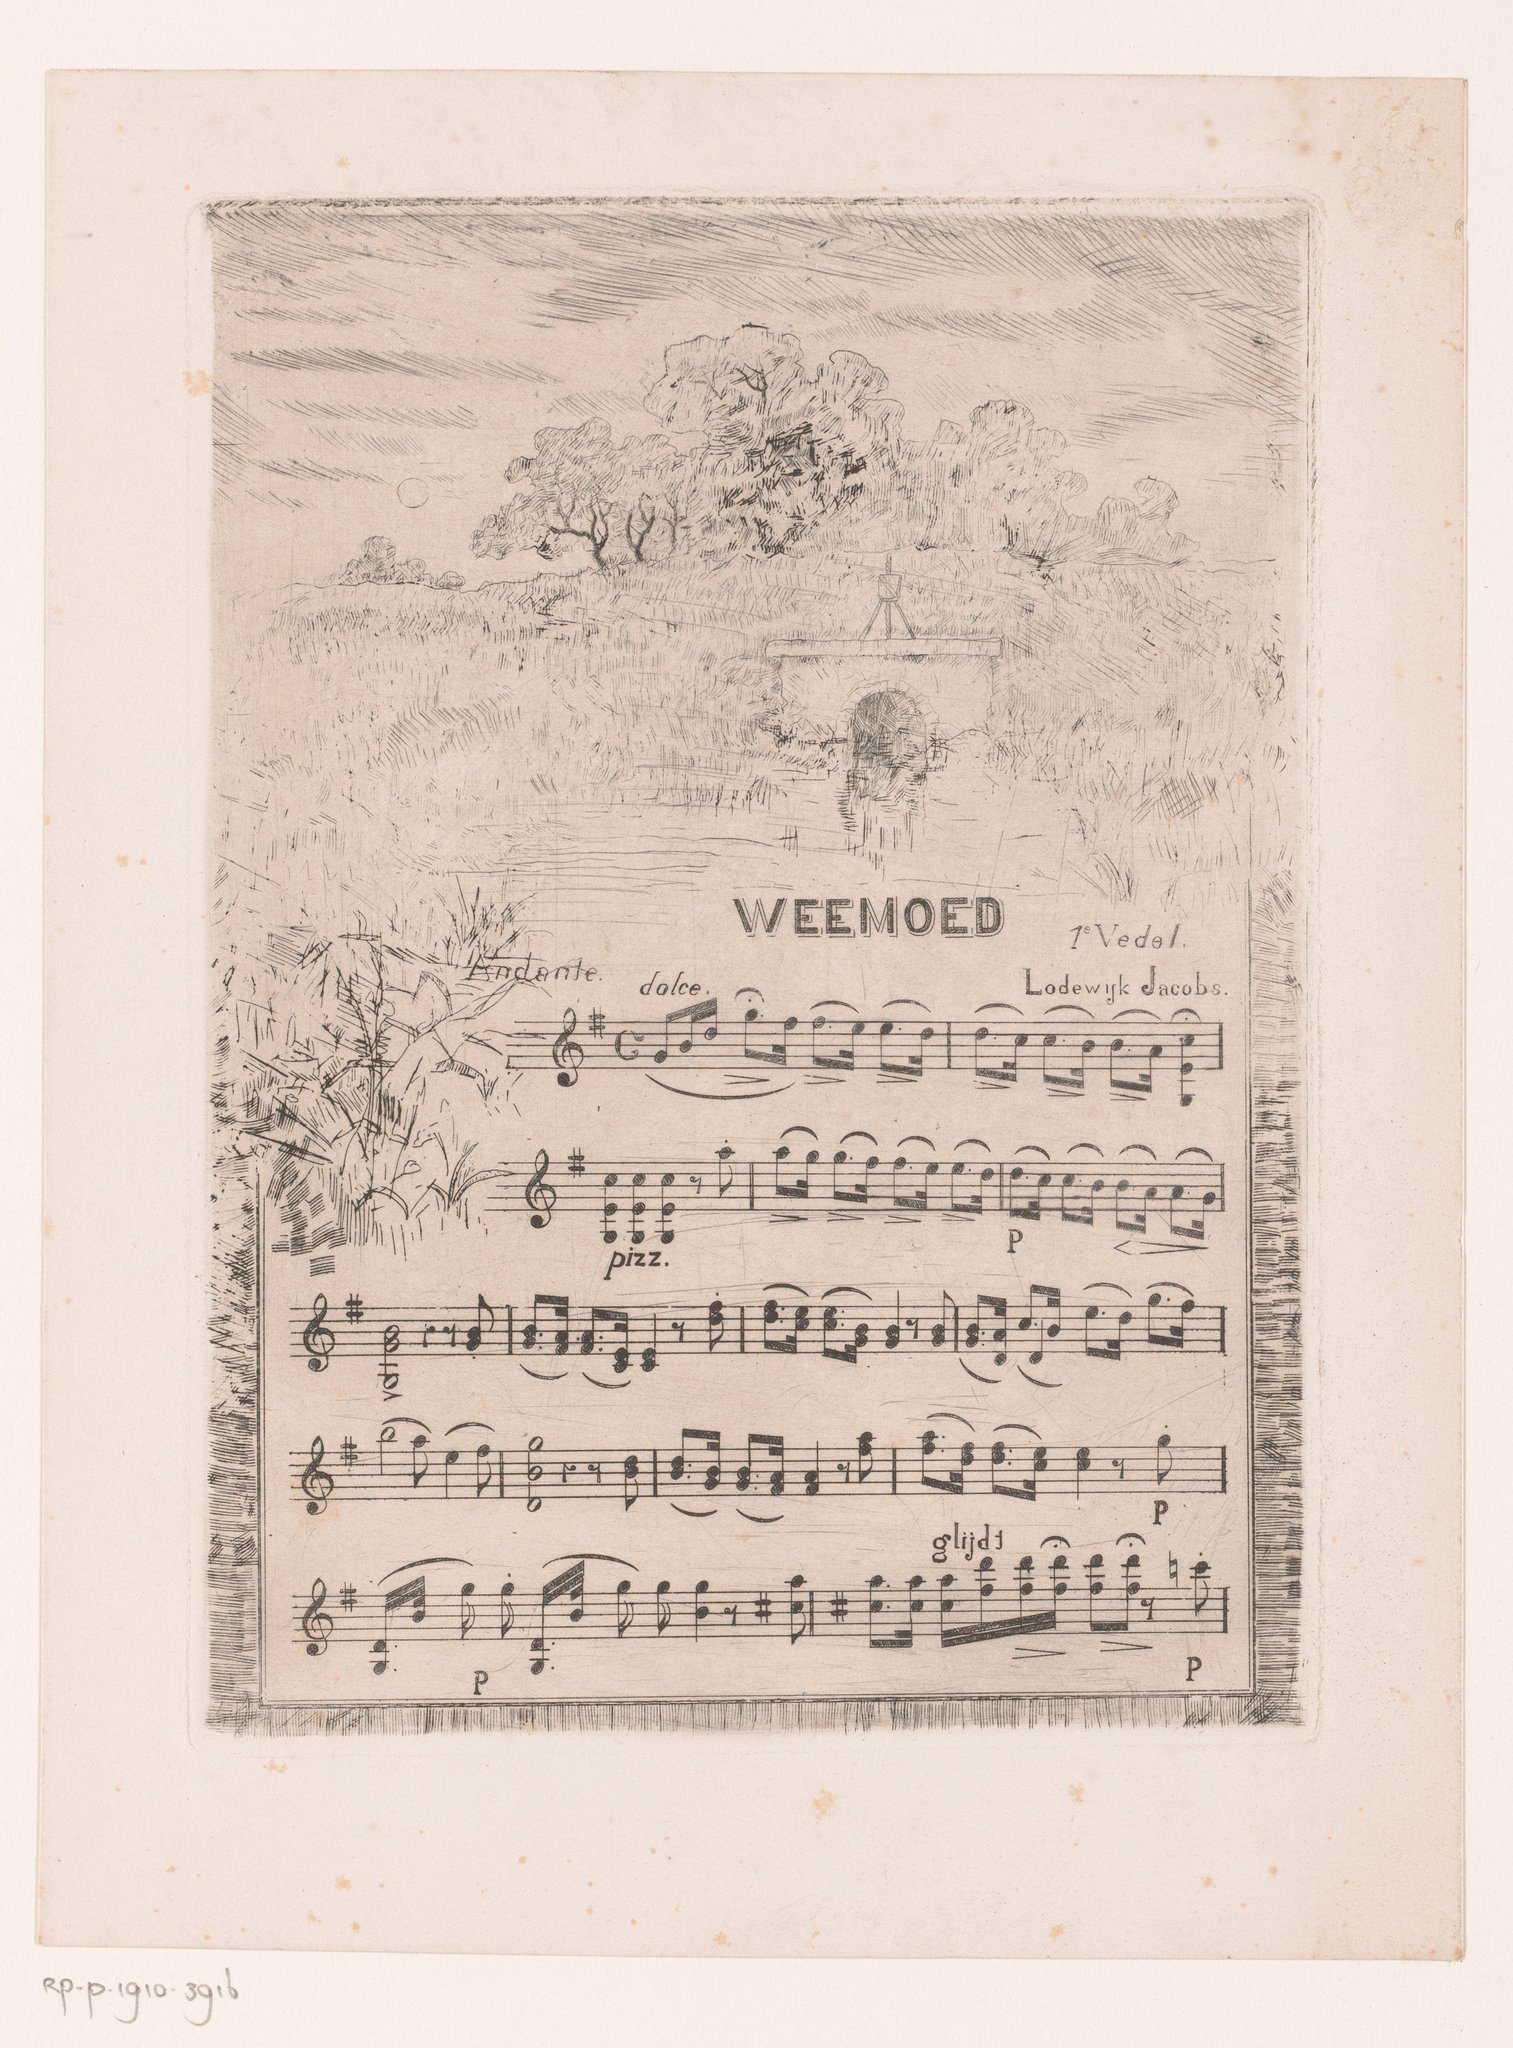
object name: print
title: Weemoed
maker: louis adolphe jacobs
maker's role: painter, print maker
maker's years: 1855-1929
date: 1865-1910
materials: paper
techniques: etching, intaglio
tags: sluice, weir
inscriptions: collector's mark: Lugt 2228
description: Bladmuziek voor vedel. Waarschijnlijk een fragment van een langer stuk.